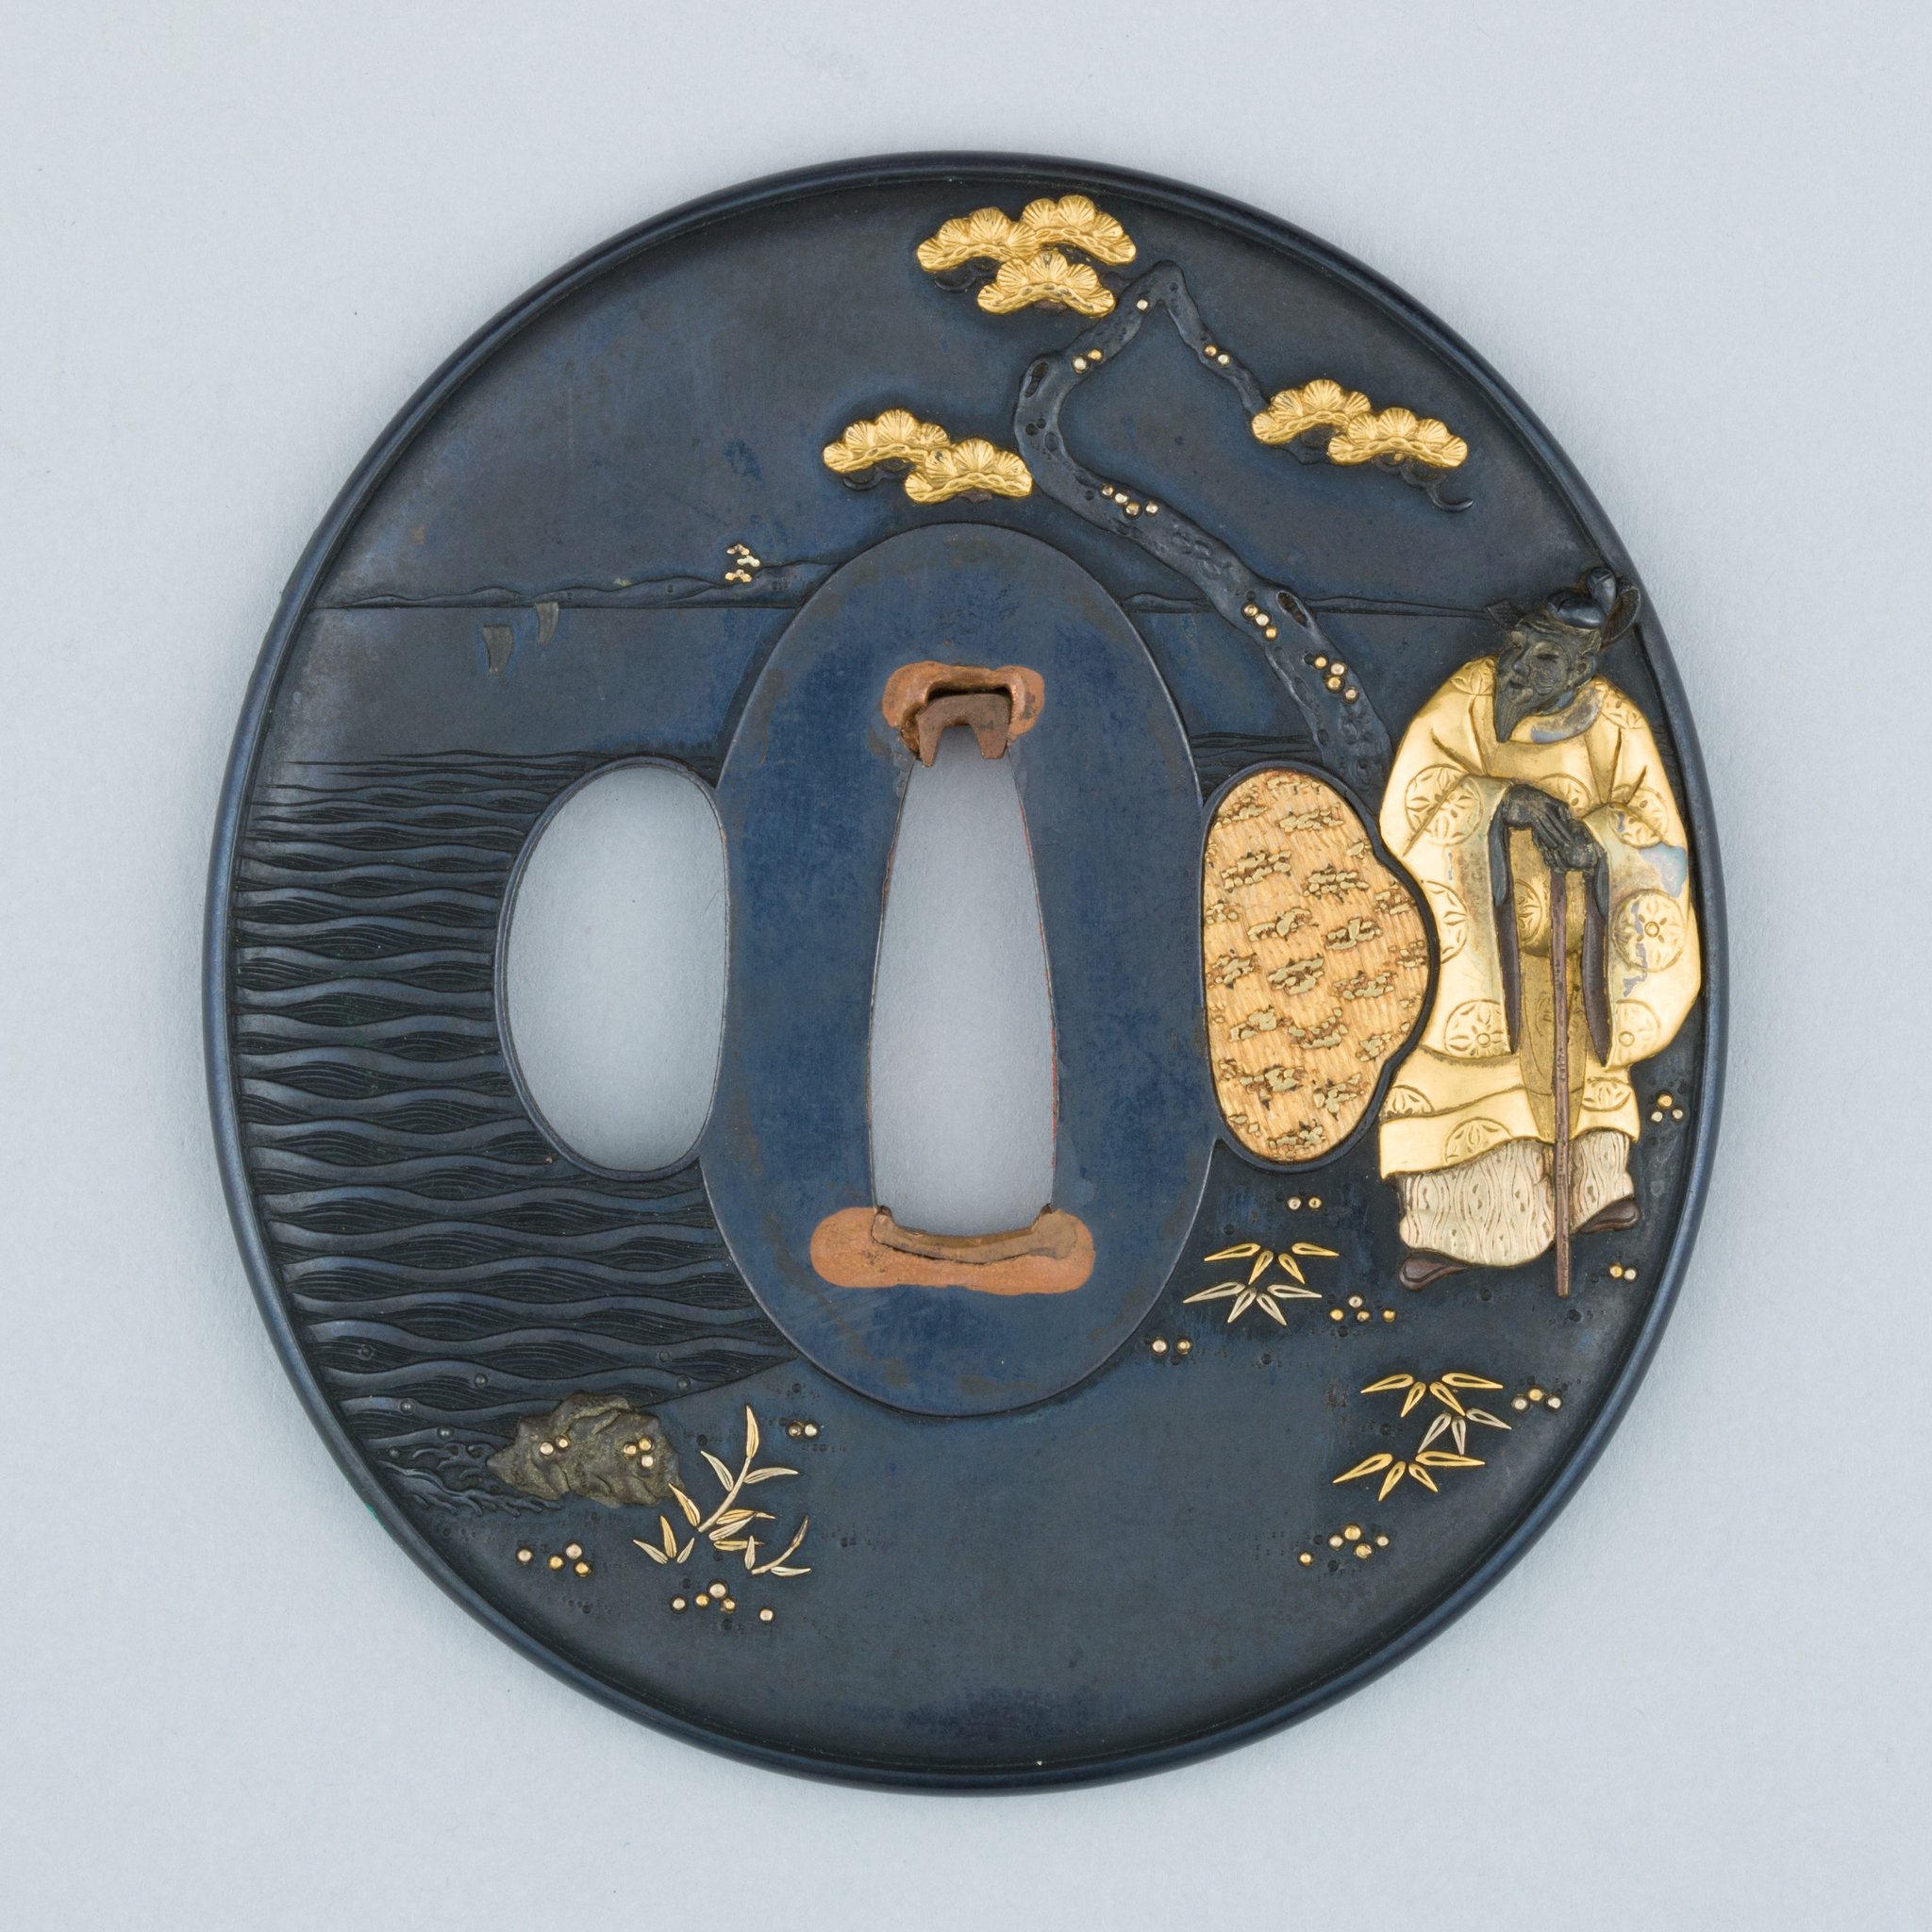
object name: sword guard tsuba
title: Sword Guard (Tsuba)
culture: japanese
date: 1615-1868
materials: gold alloy, silver alloy, gold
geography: japan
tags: men,trees